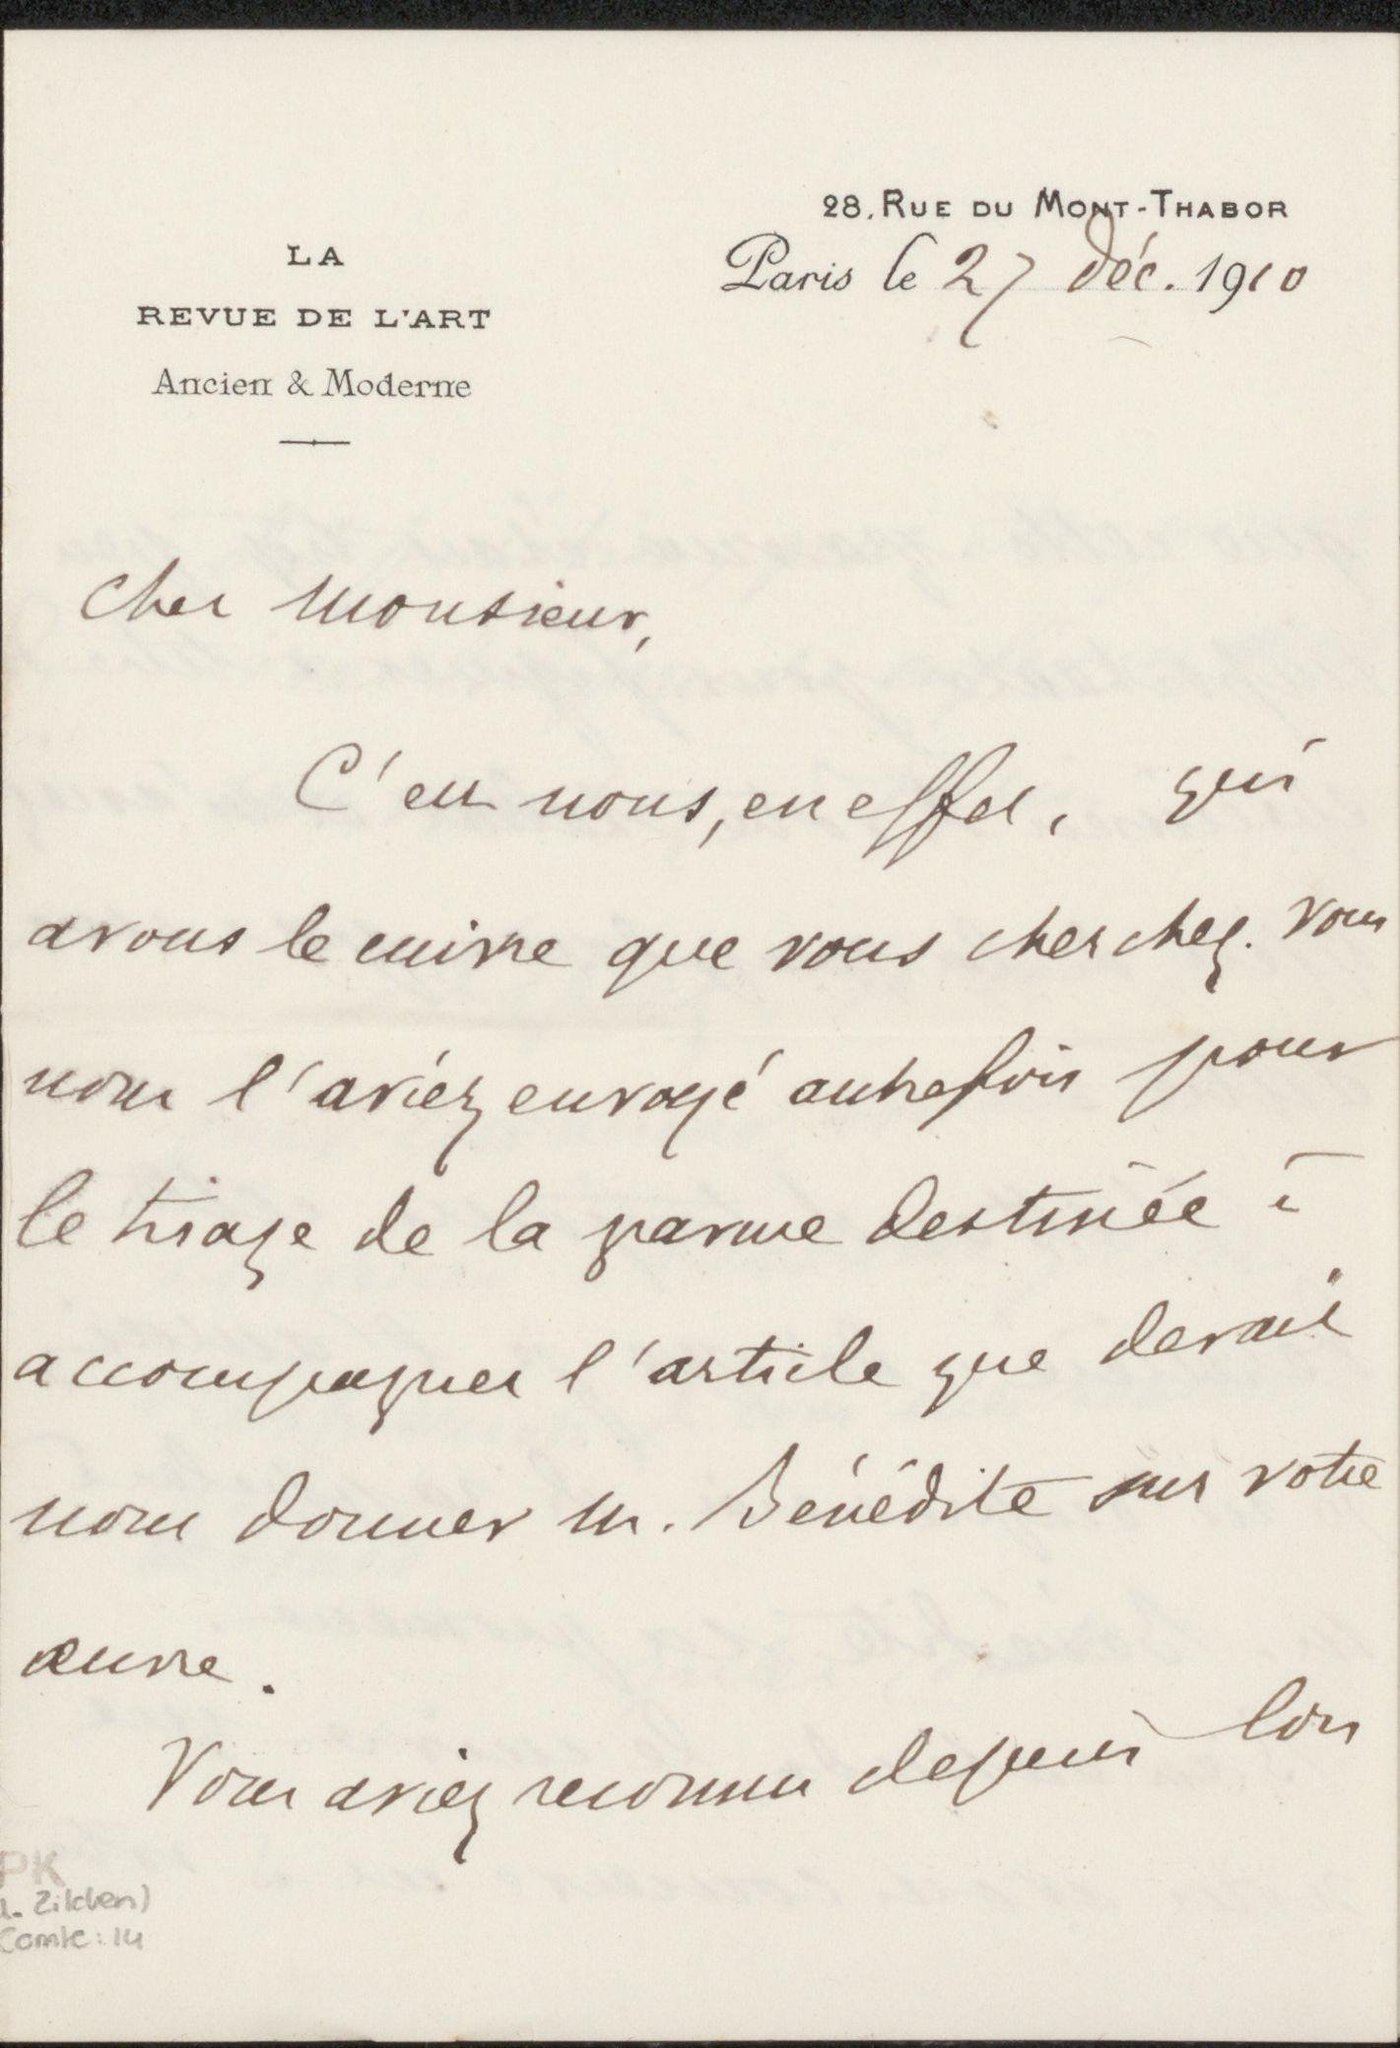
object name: letter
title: Brief aan Philip Zilcken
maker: jules comte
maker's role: official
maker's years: 1846-1912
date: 1910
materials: ink, paper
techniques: pen, printing, writing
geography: paris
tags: léonce bénédite, the hague, draughtsman, philip zilcken, the graphic arts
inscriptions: collector's mark: ‘RPK’, watermark